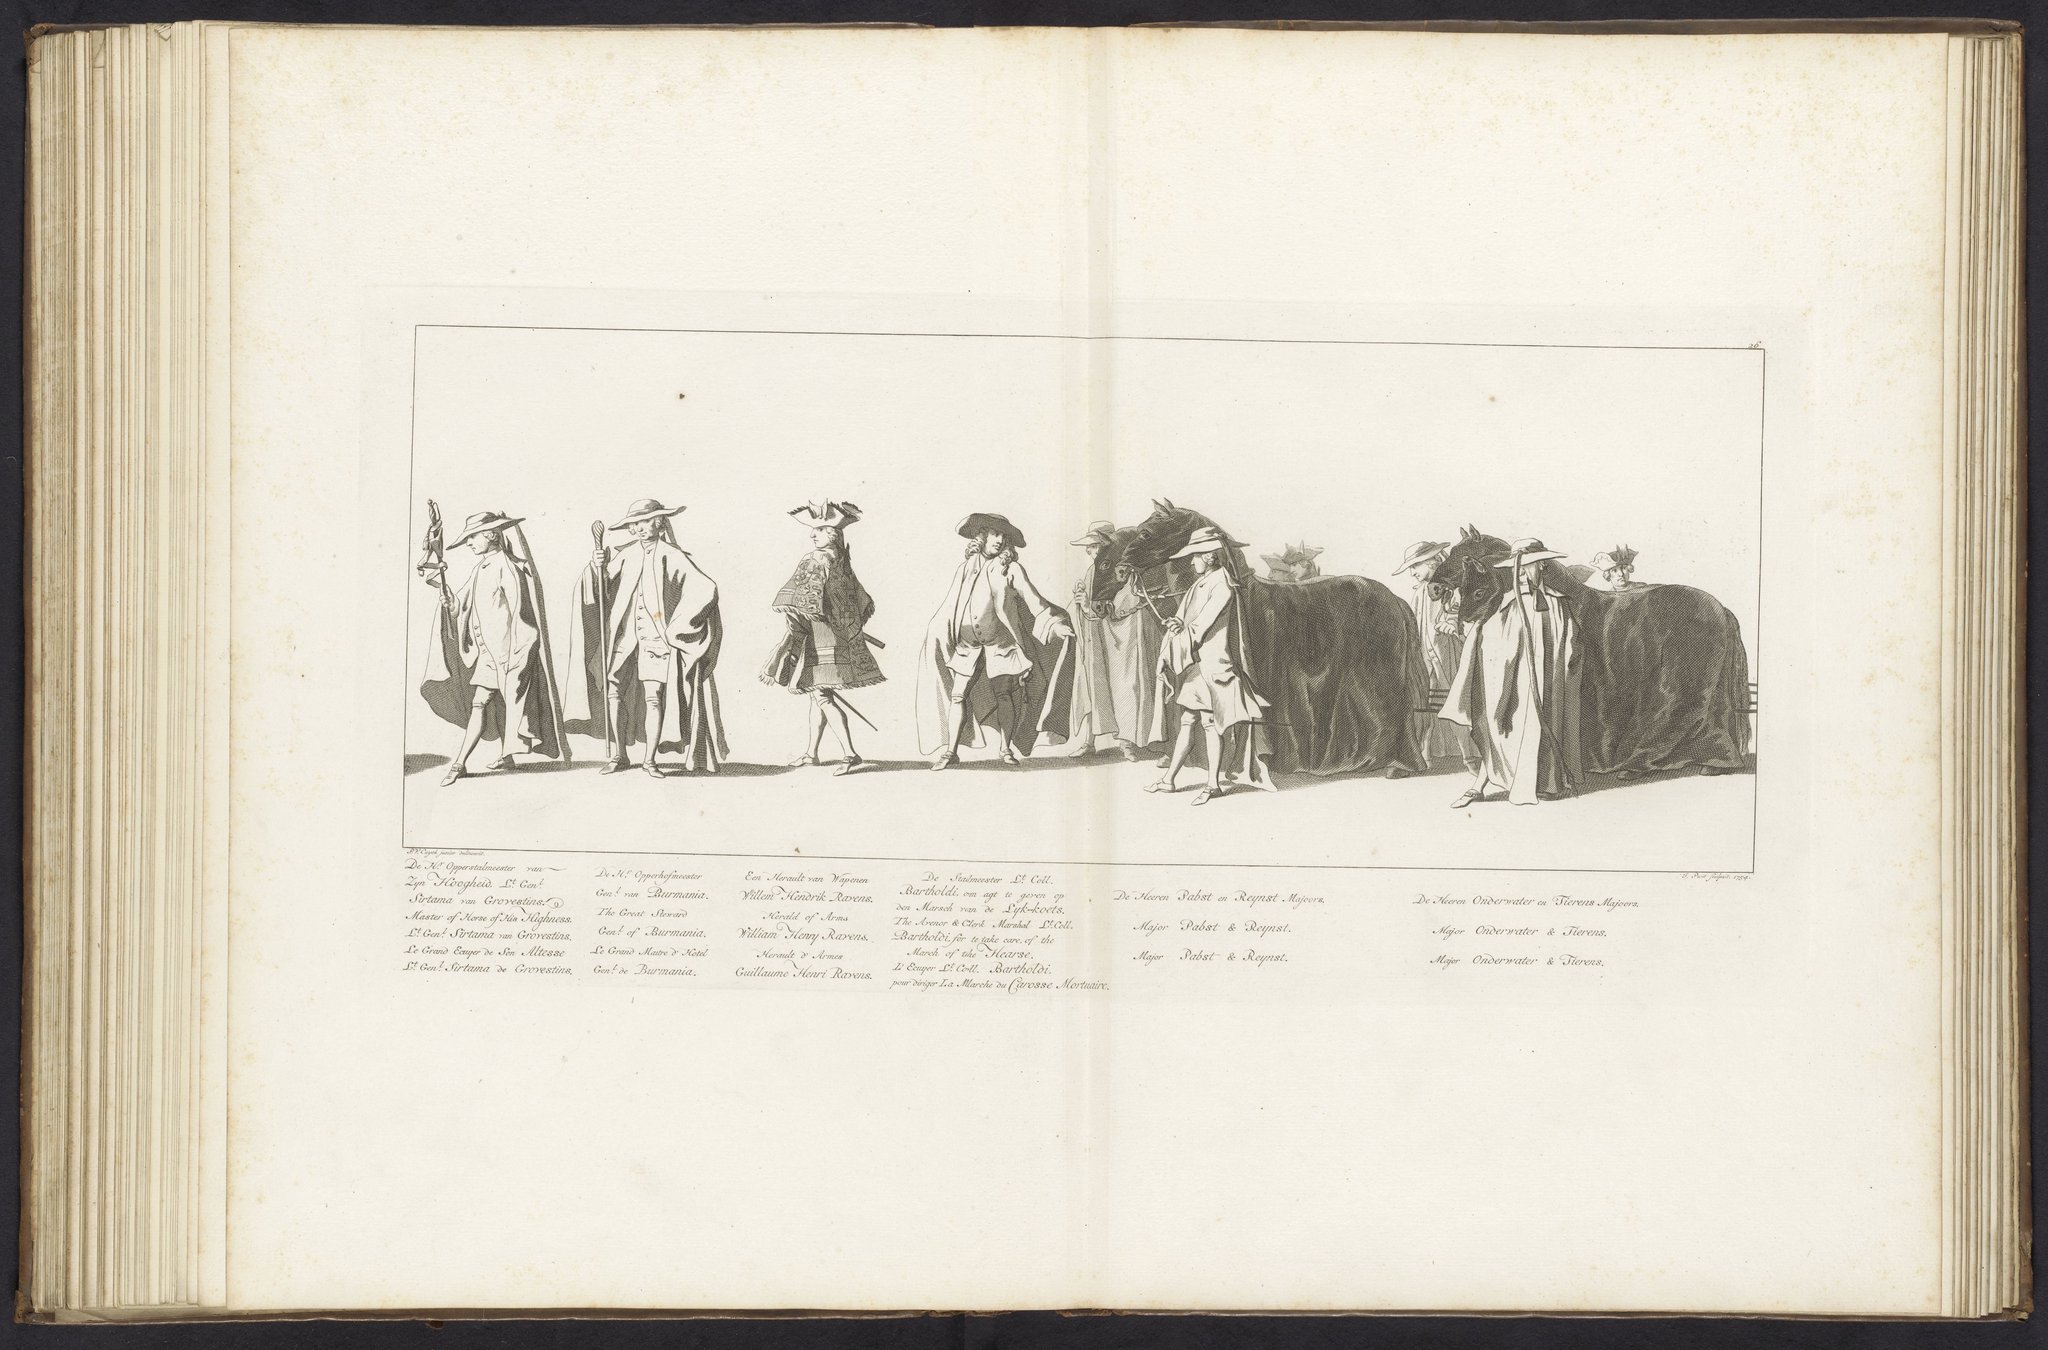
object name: print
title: Lijkstatie van Willem IV, 1752, plaat 26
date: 1754-1755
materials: paper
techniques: engraving, etching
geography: northern netherlands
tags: the hague, willem iv (prins van oranje-nassau), cortege, funeral procession, royal household; courtiers, retinue, train, delft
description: Leden van de stadhouderlijke huishouding gevolgd door de eerste twee spannen paarden die de lijkwagen trekken. In de marge het onderschrift in Nederlands, Frans en Engels. Onderdeel van een serie van 41 platen van de begrafenisstoet van stadhouder Willem IV te Delft op 4 februari 1752. Genummerd rechtsboven: 26. In de gebonden uitgave van 1755.